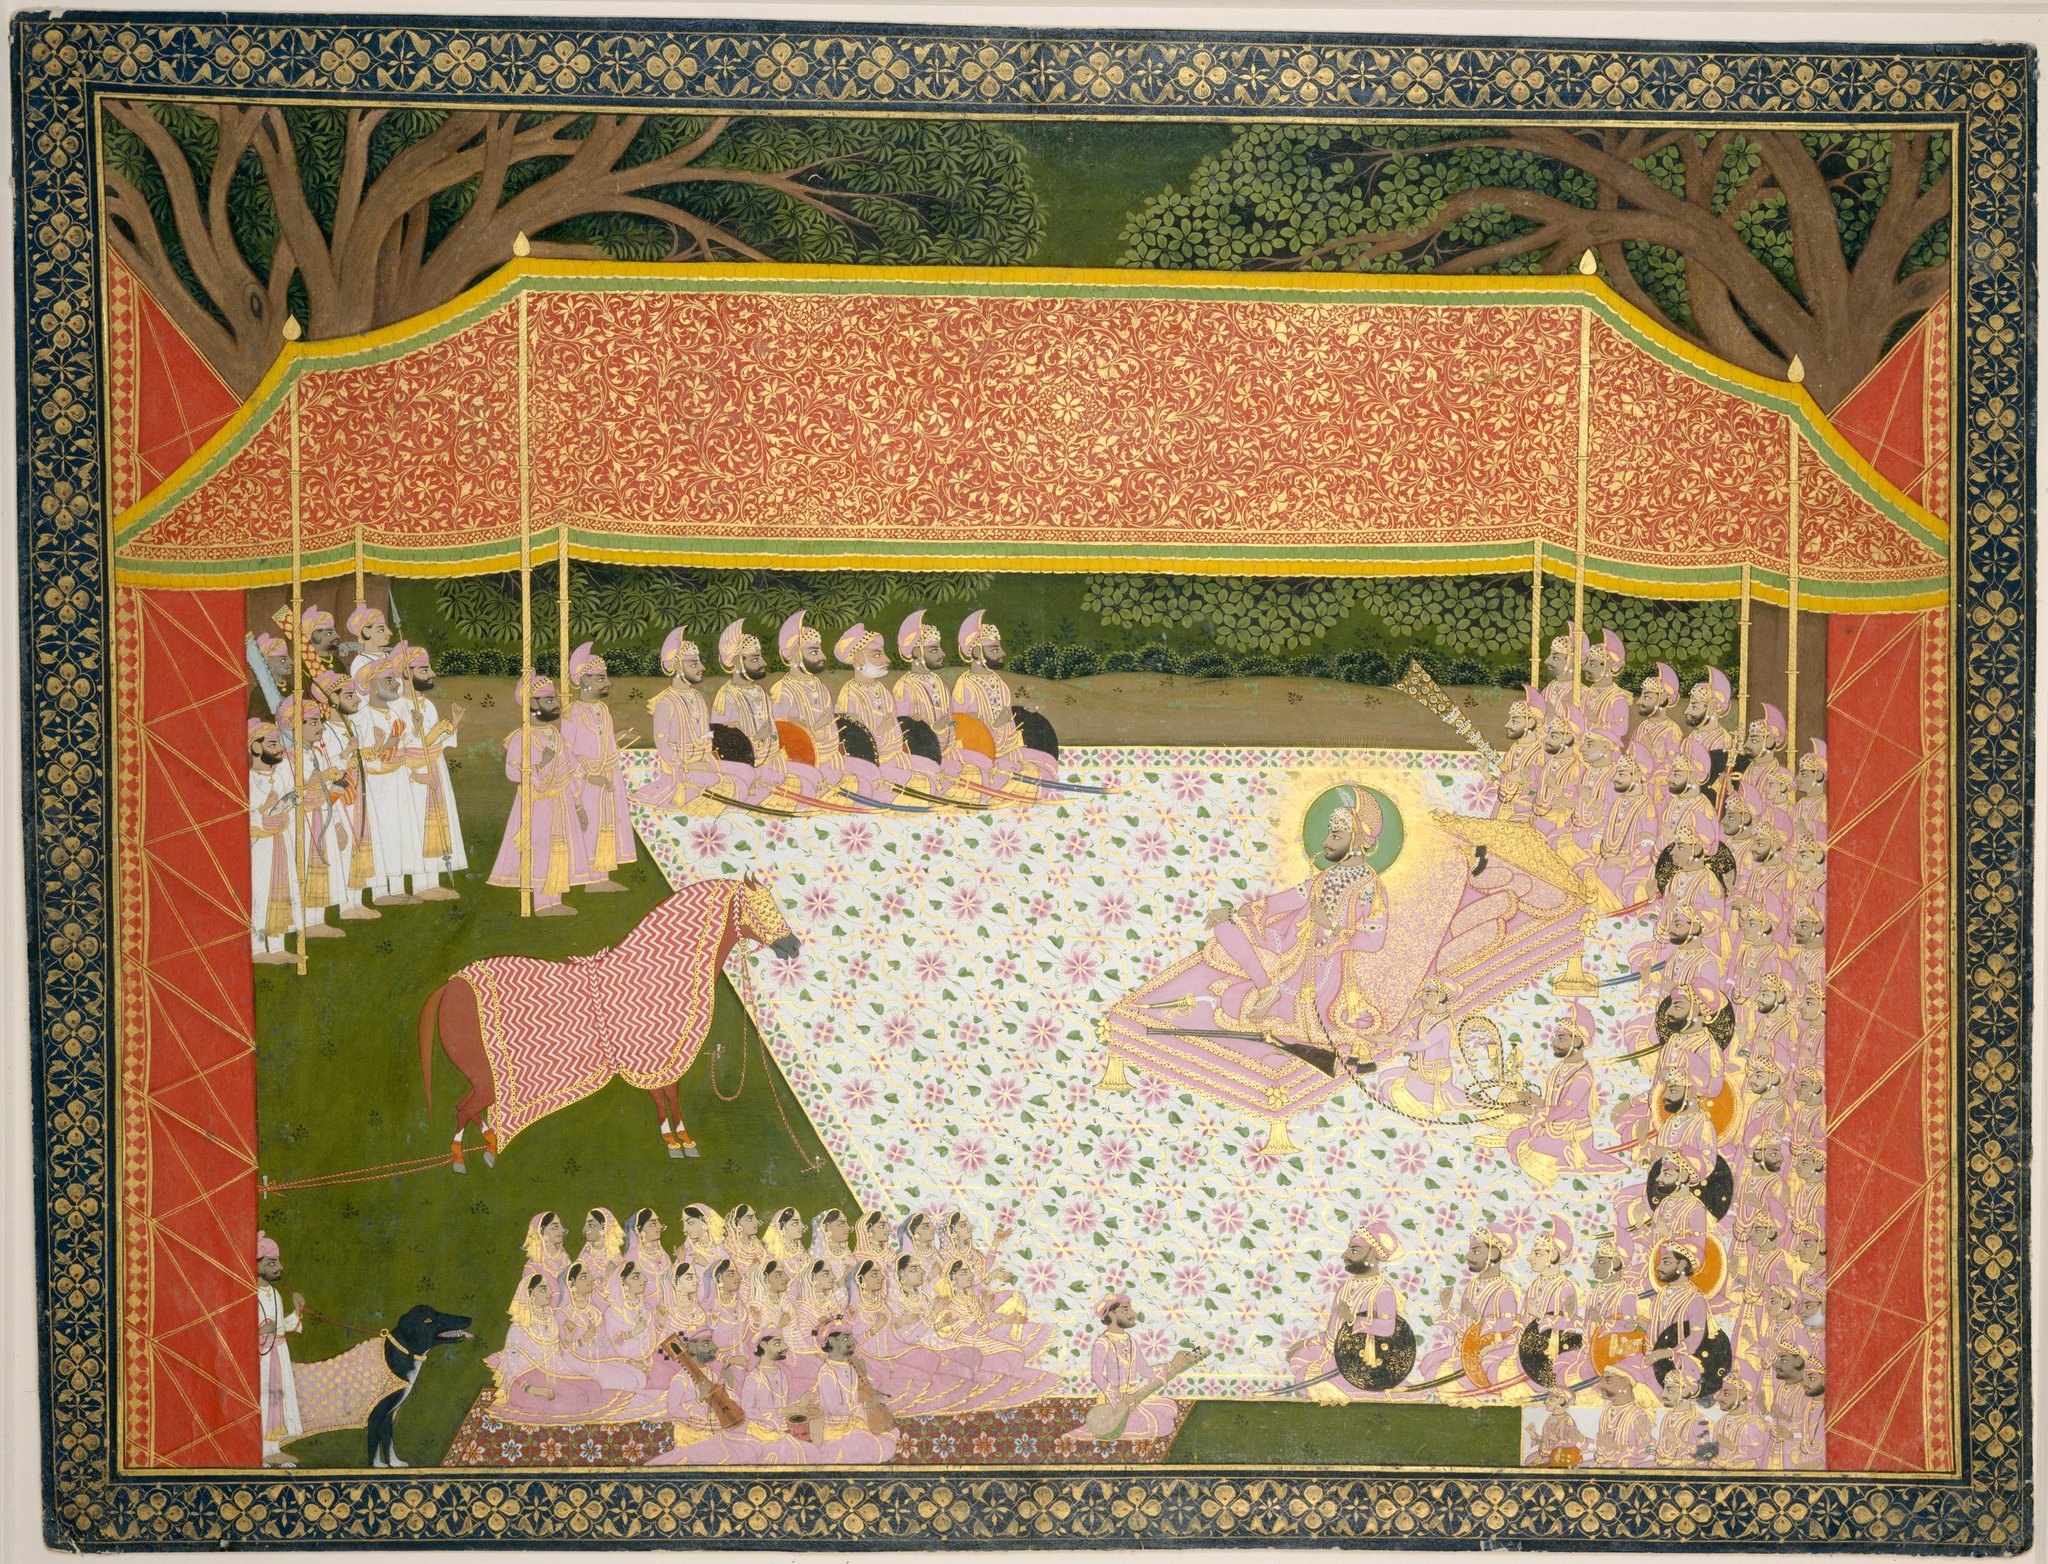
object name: painting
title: Maharana Sarup Singh Inspects a Prize Stallion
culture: western indian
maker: tara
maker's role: artist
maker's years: 1836-1870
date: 1845-1846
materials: gold, ink, paper, watercolor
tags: tents,men,dogs,horses